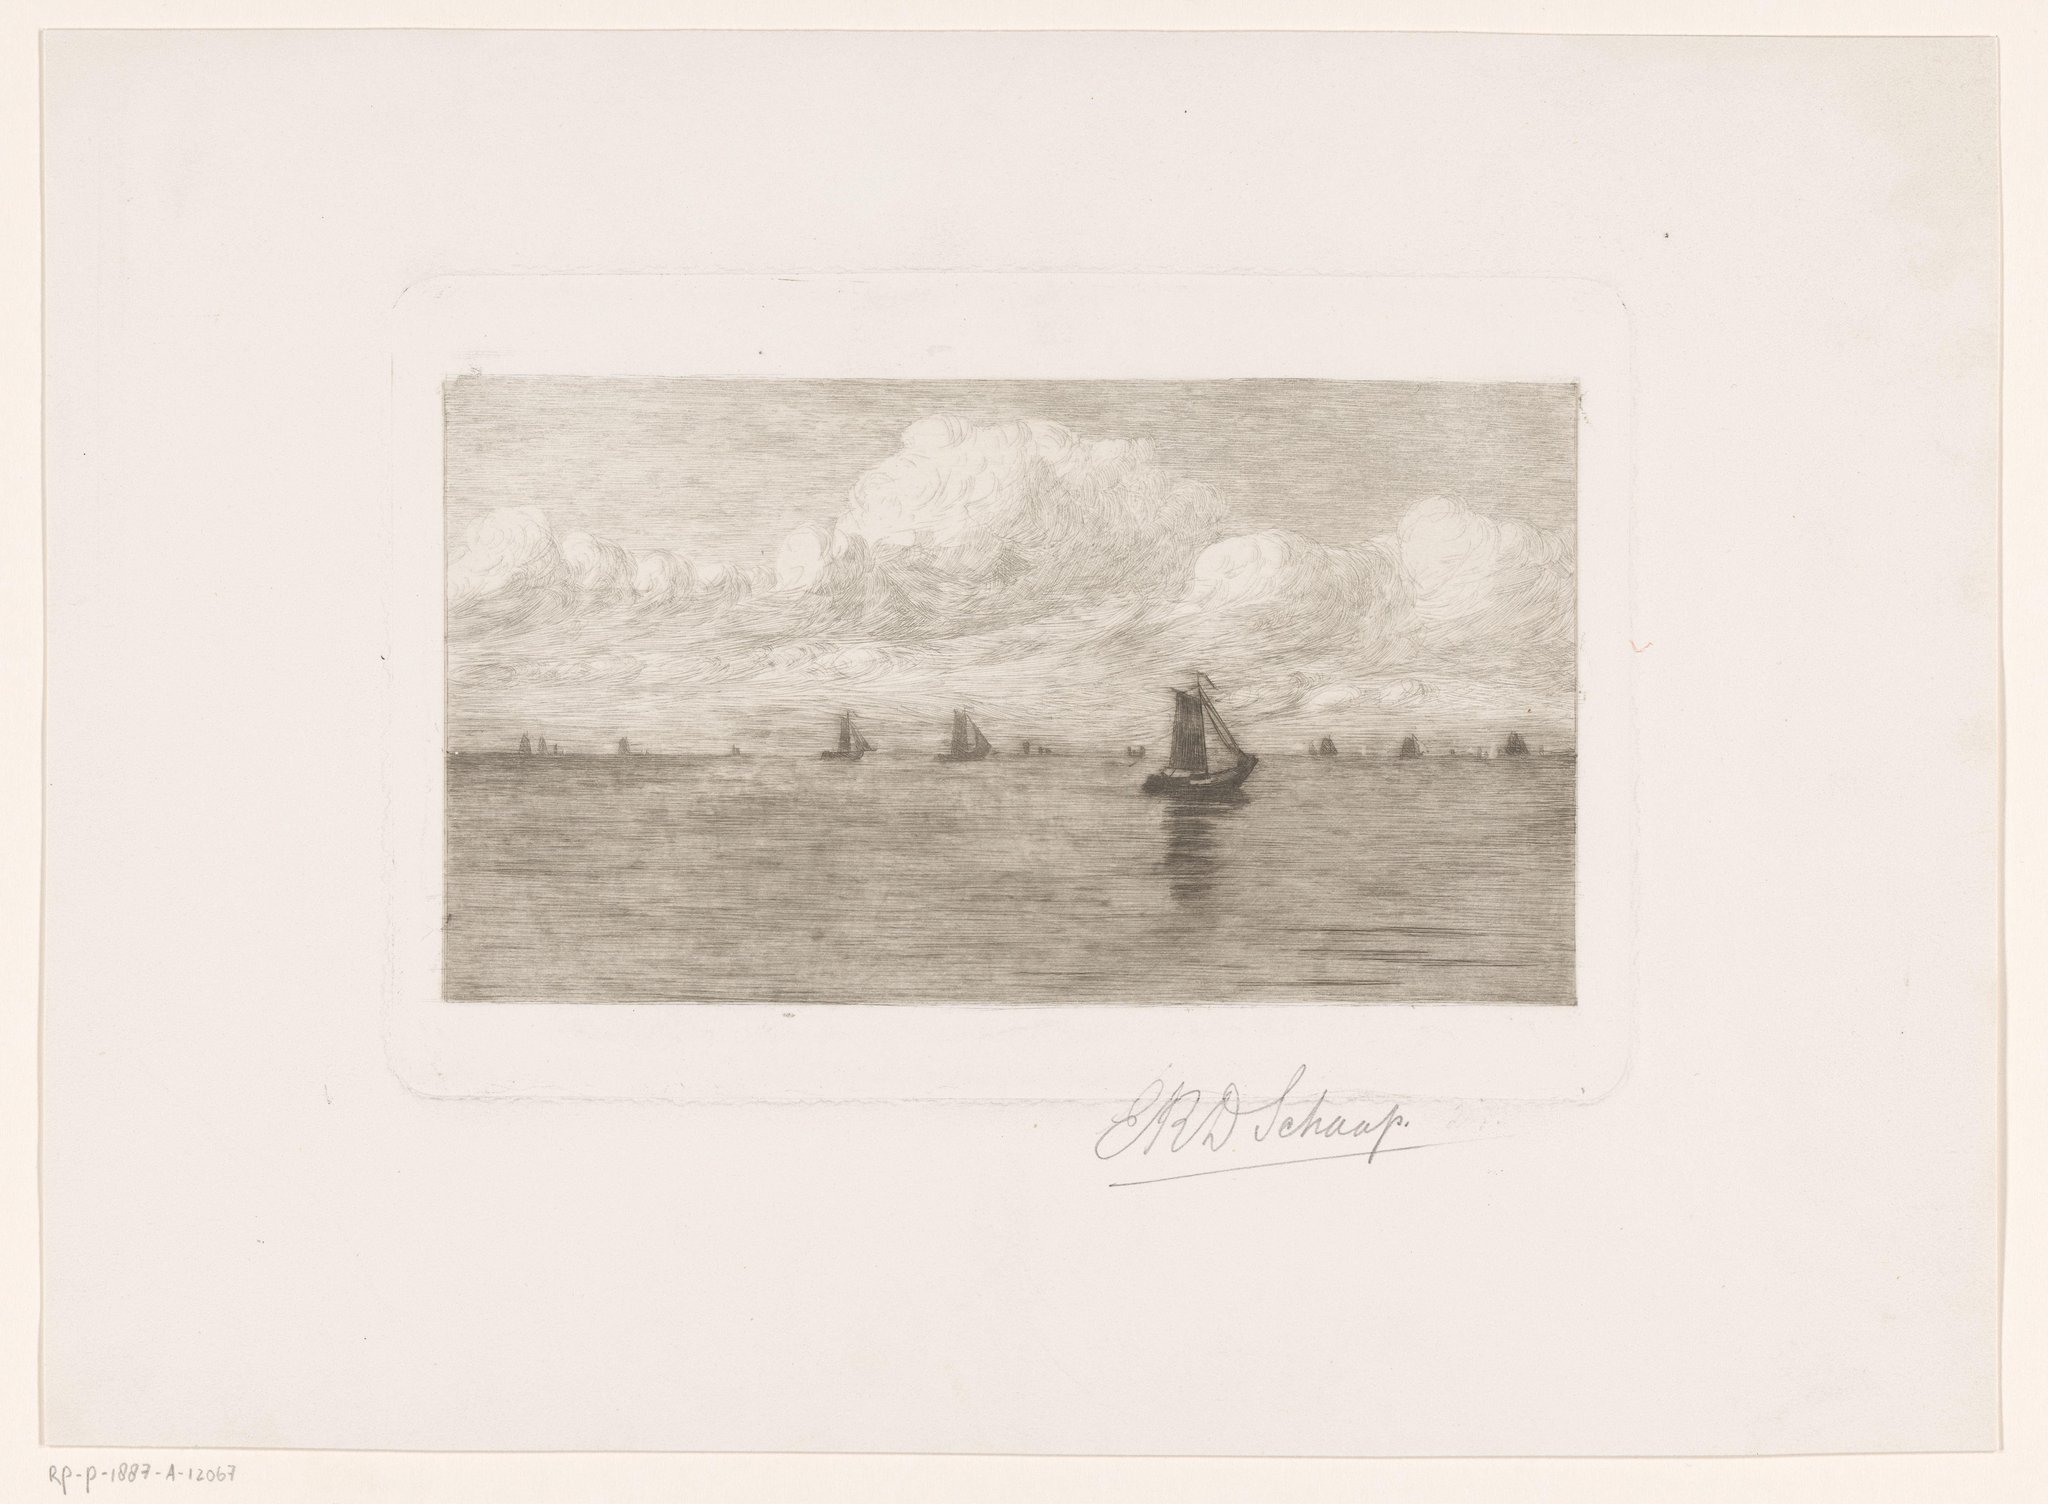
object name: print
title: Gezicht op water met zeilboten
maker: egbert rubertus derk schaap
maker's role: draughtsman, painter, print maker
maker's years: 1862-1939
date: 1877-1887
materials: paper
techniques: etching, intaglio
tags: sailing-ship, sailing-boat, water course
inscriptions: collector's mark: Lugt 2228